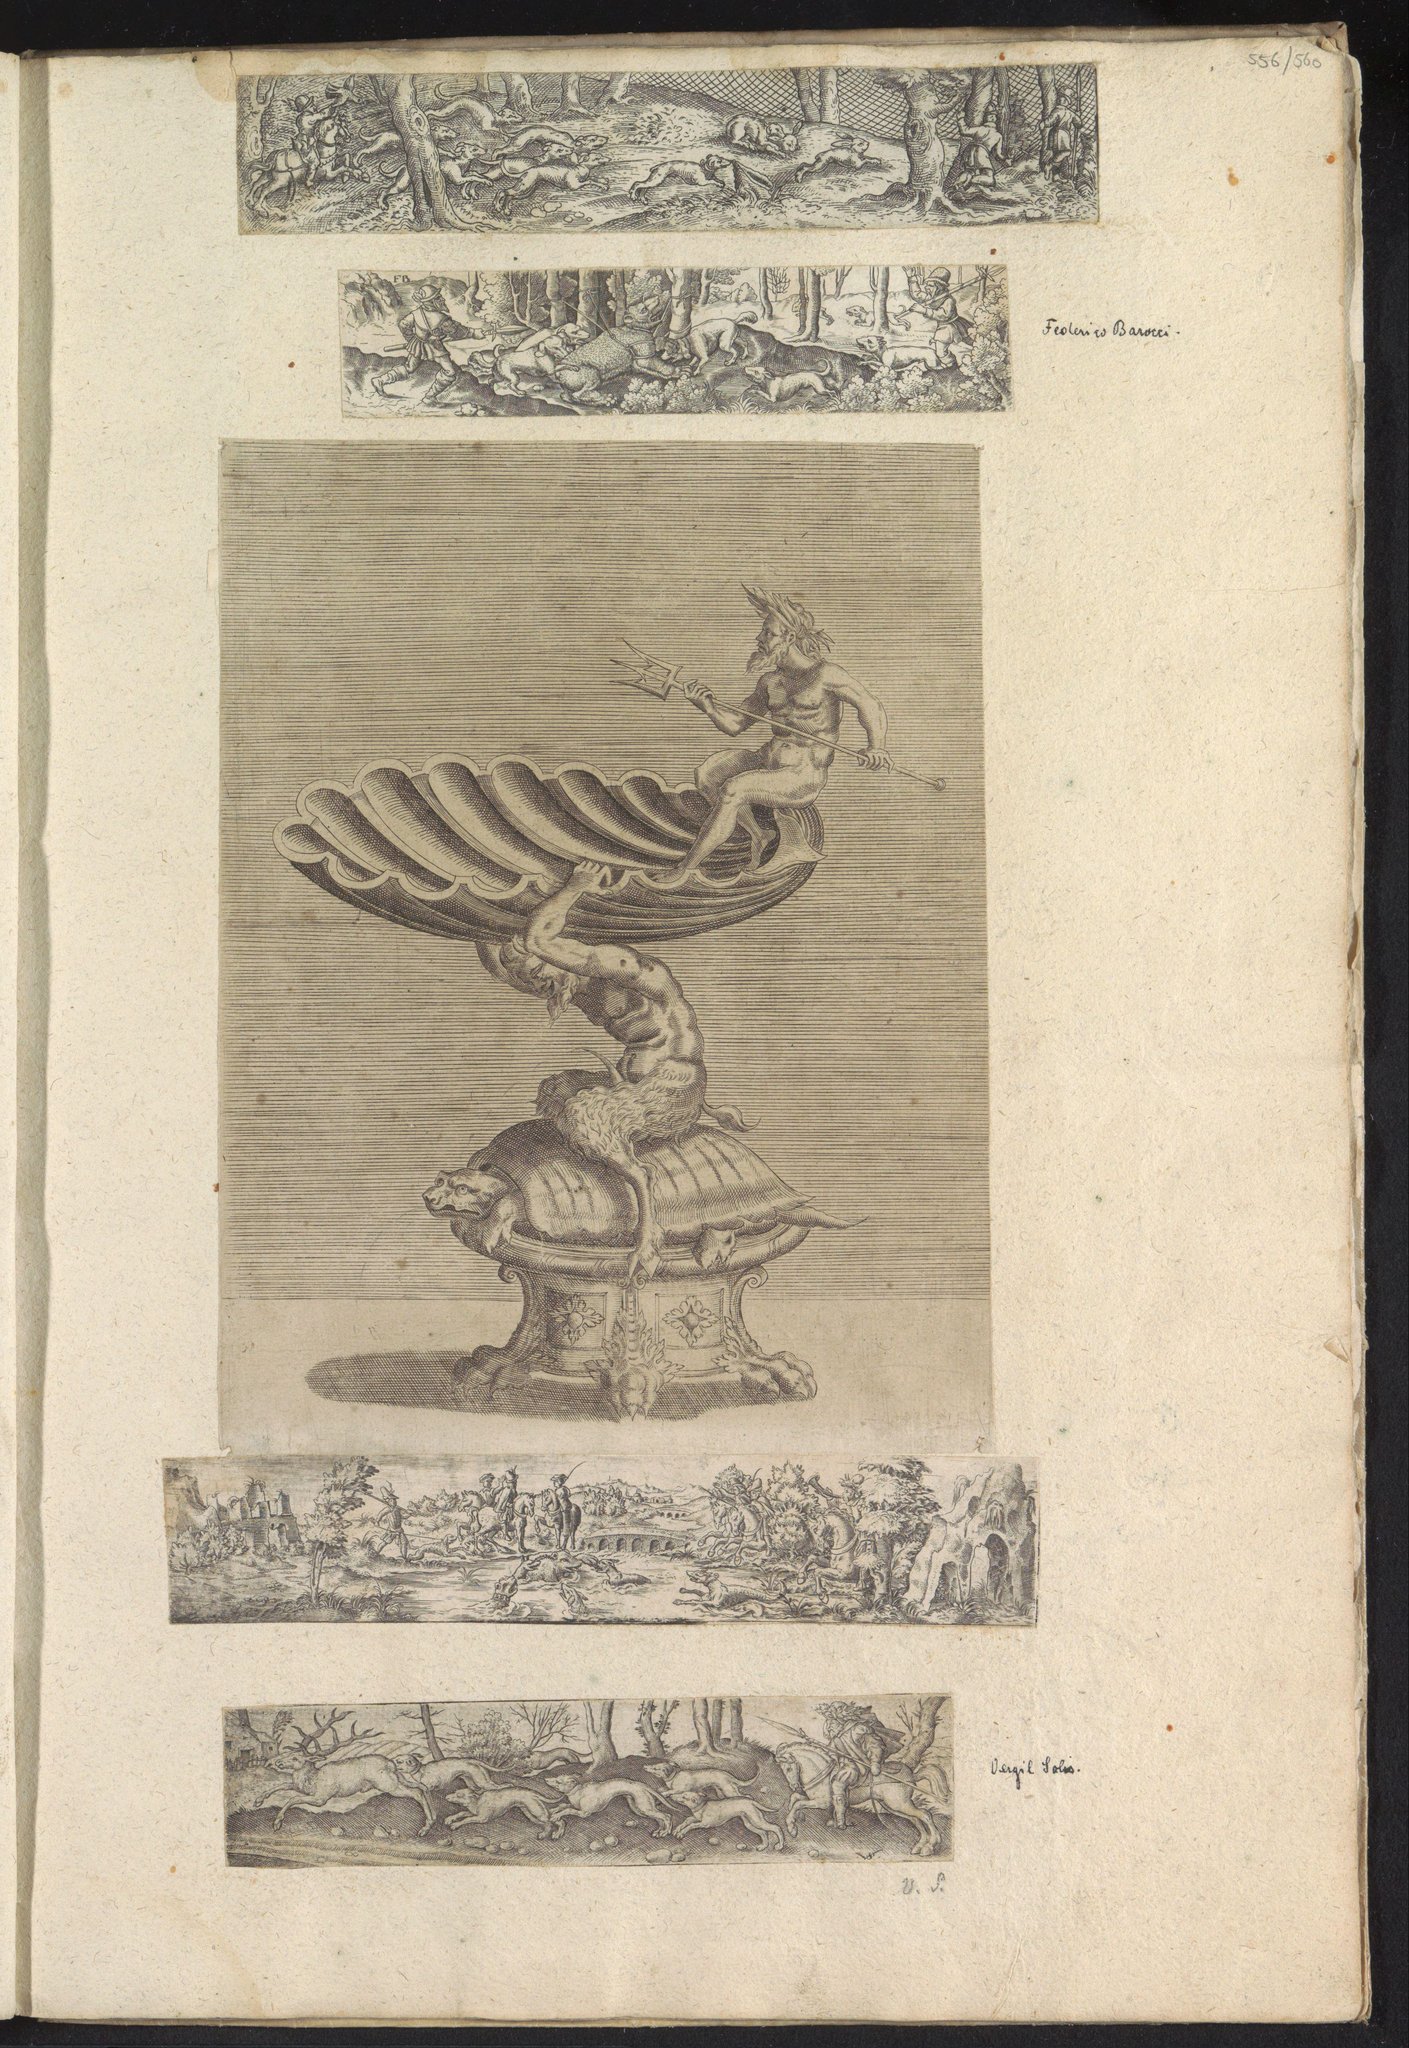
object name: ornament print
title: Albumblad met vijf prenten met een schaal en jachtscènes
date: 1500-1599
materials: paper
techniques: engraving, etching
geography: germany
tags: stag-hunting, boar-hunting, hunters hunting (n.b.: in 1988-1990 this notation denoted the concept of 43c11421 'hunters resting during the hunt'), hunt ~ mammals, dish, plate, saucer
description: Albumblad met vijf uitgeknipte prenten: vier jachtscènes en een ornamentele schaal op een hoge poot.